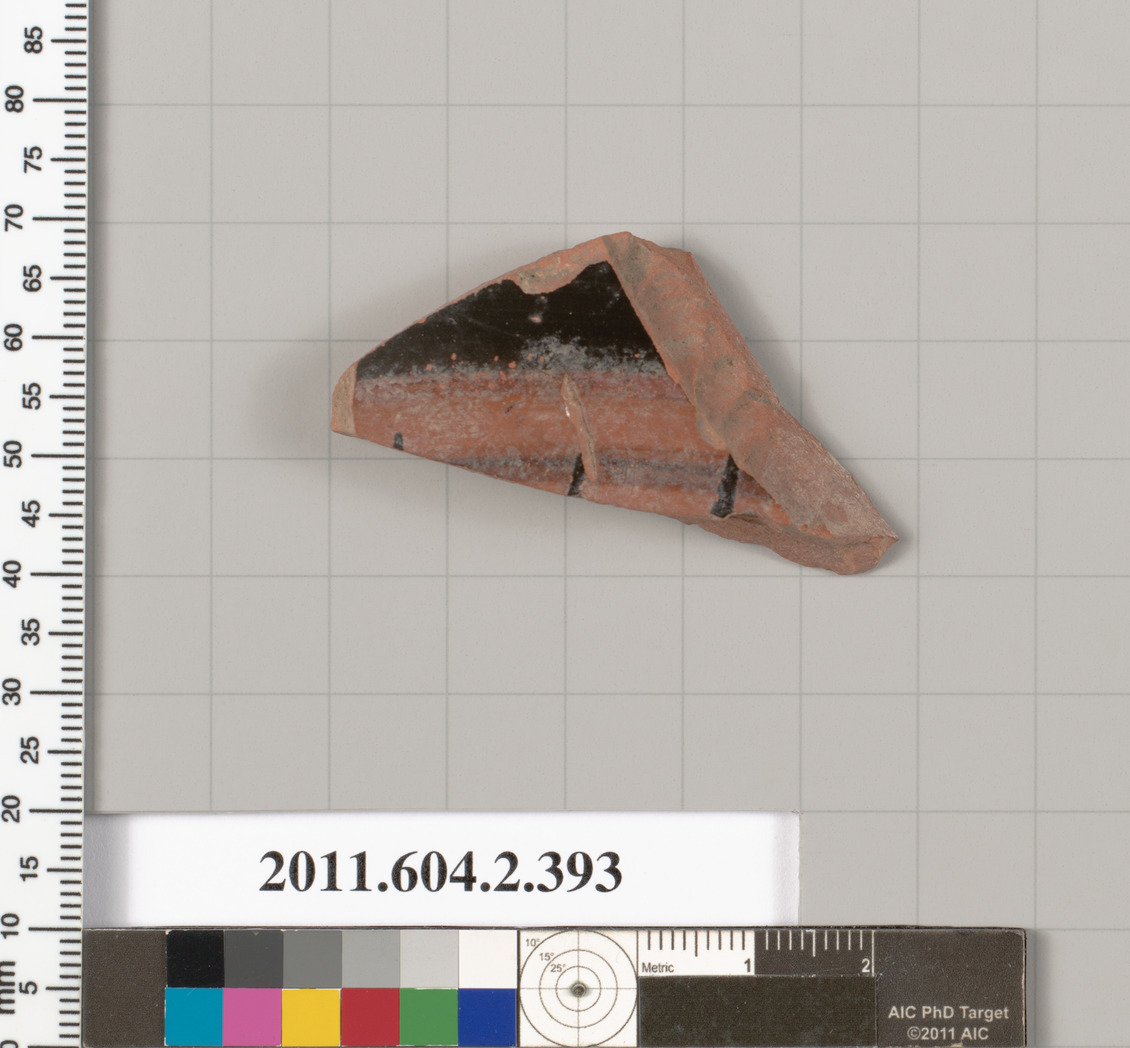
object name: column krater fragment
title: Terracotta fragment of a column-krater (bowl for mixing wine and water)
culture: greek, attic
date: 460-440 BCE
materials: terracotta